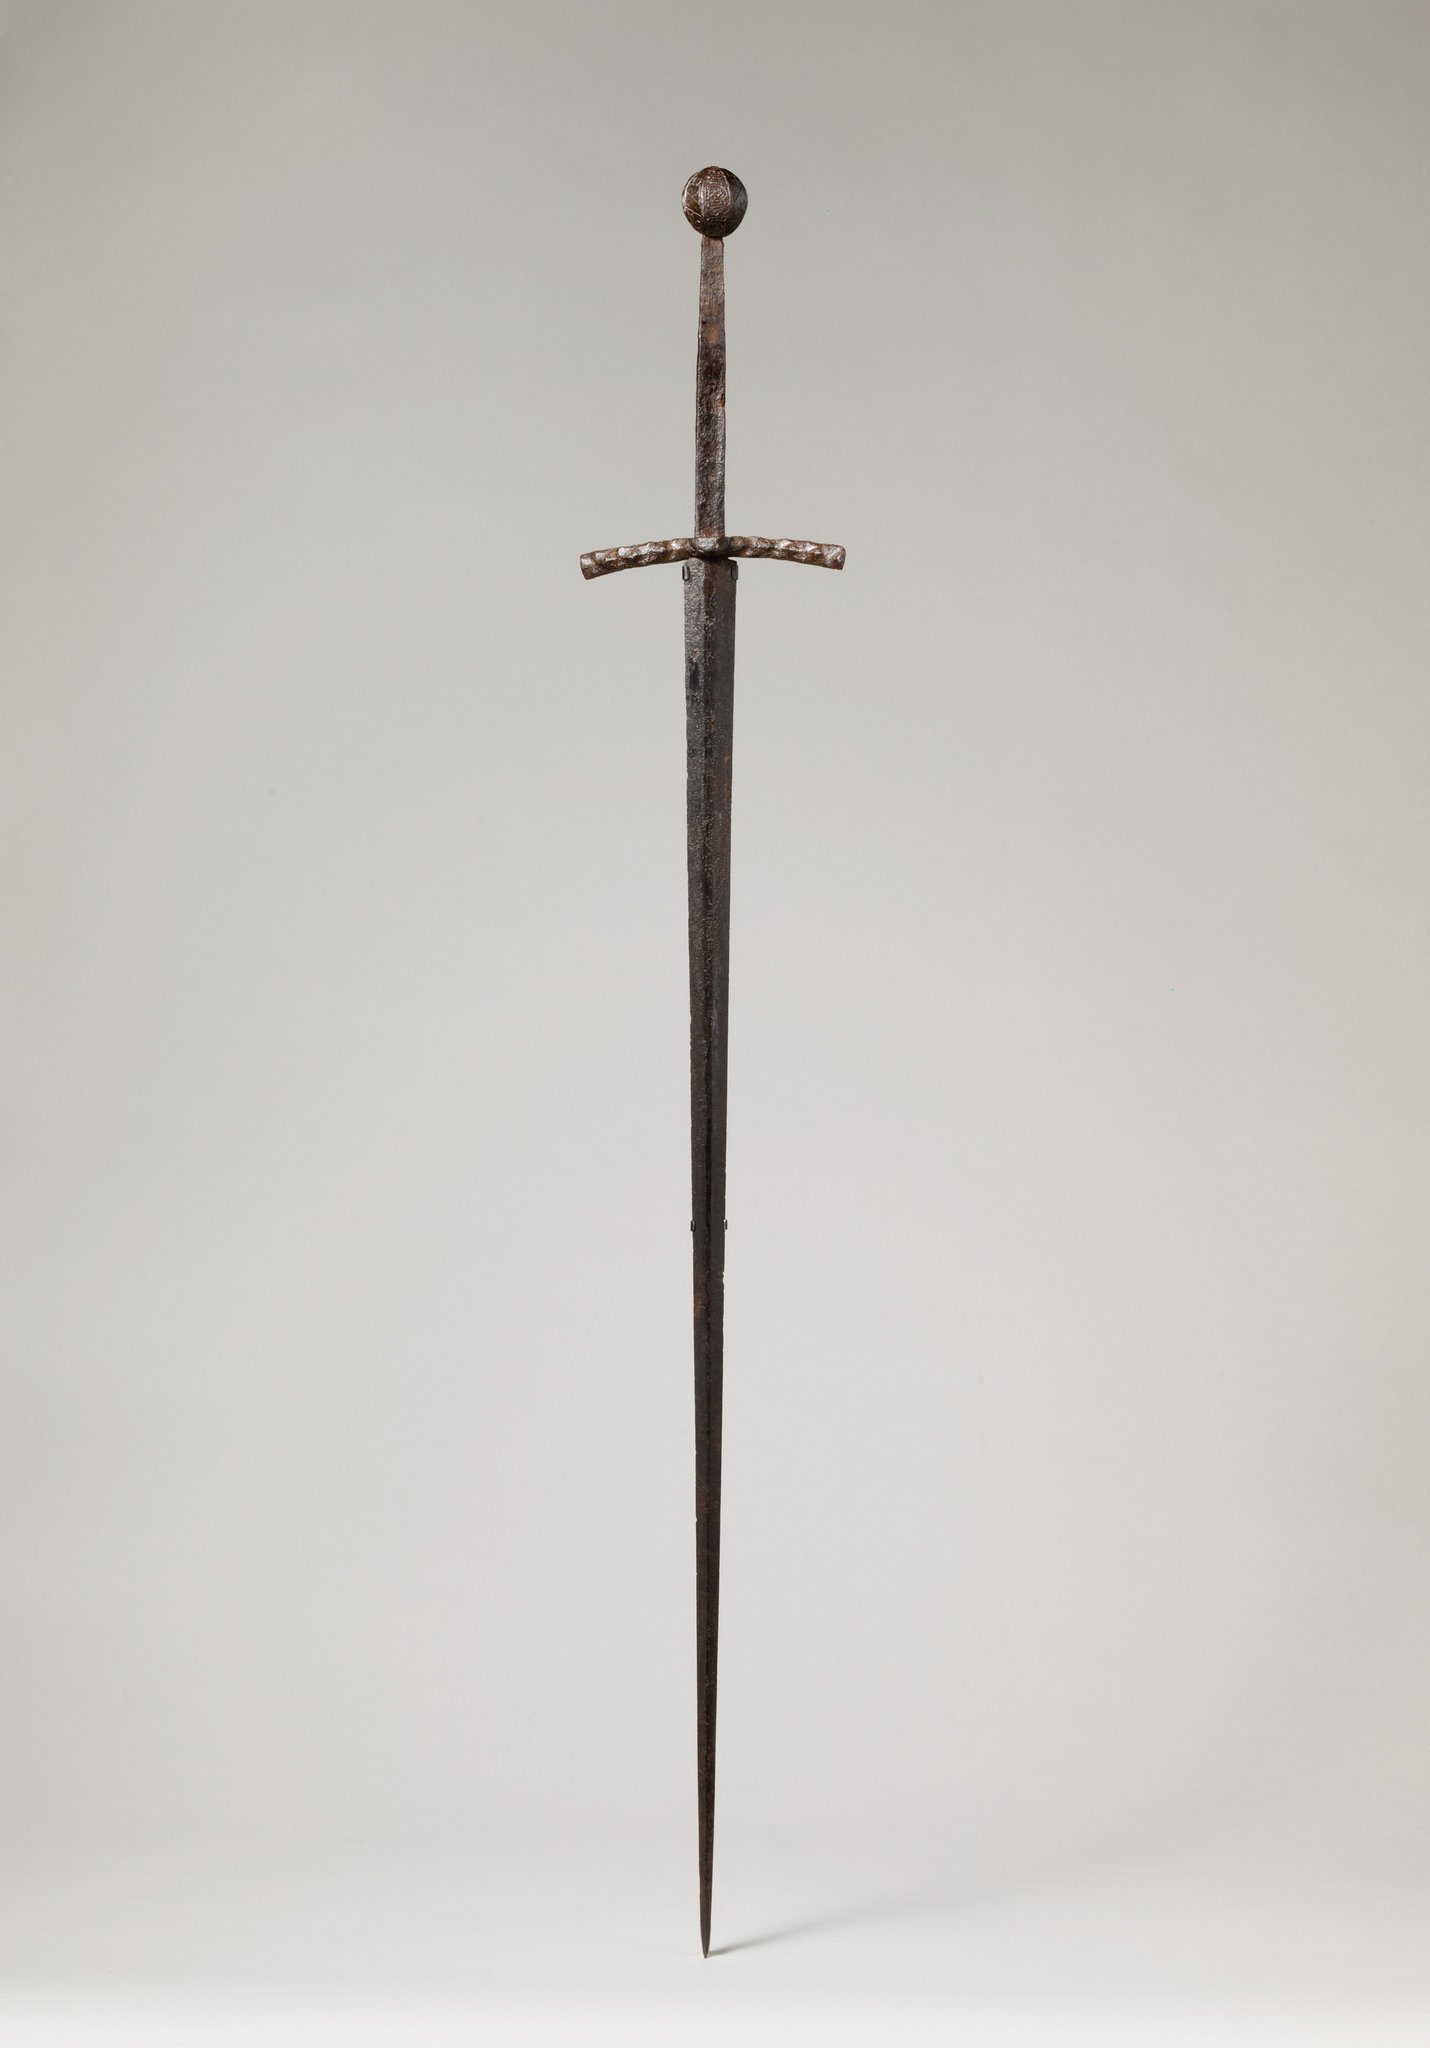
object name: hand and a half sword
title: Hand-and-a-Half Sword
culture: german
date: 1400-1430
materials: copper alloy, steel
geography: germany